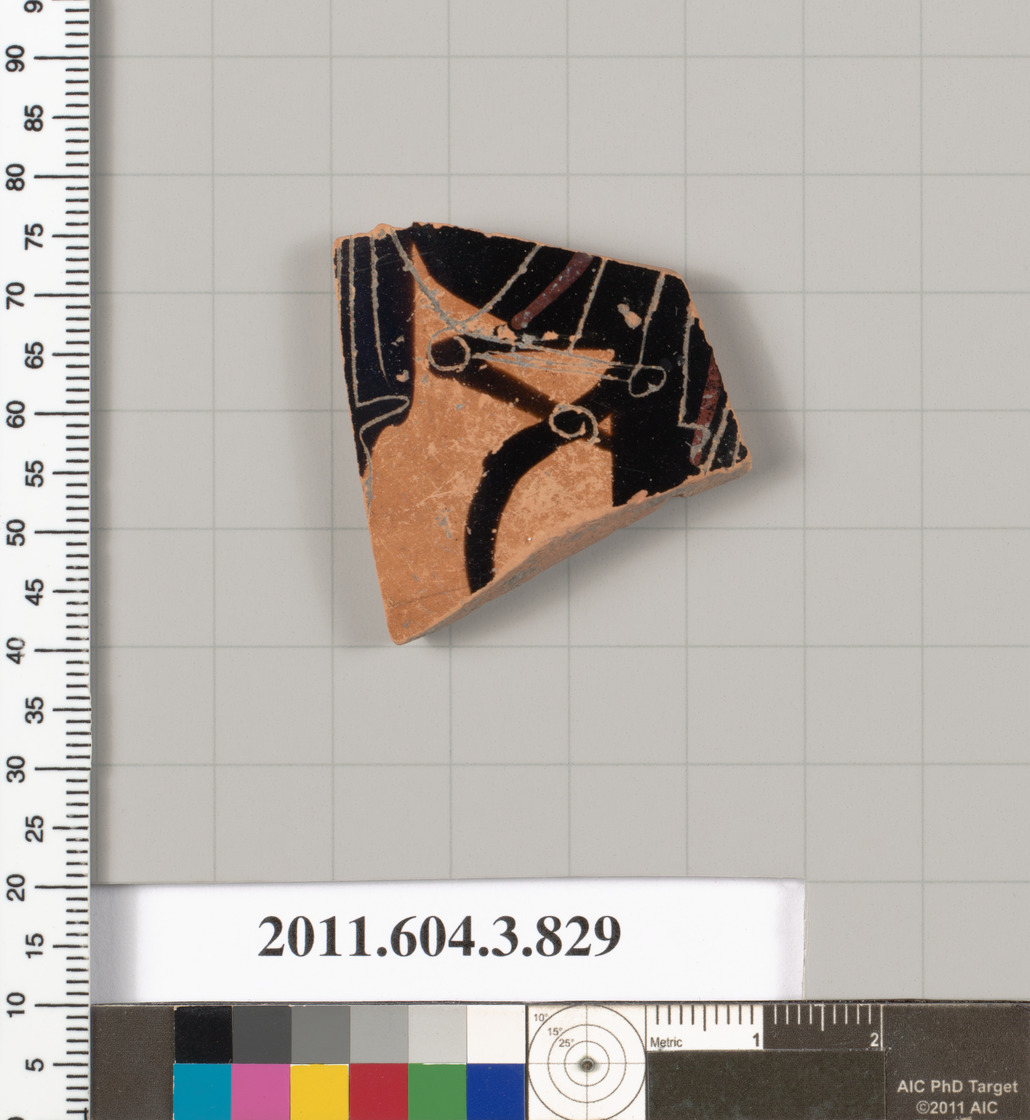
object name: lekythos fragment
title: Terracotta fragment of a lekythos (oil flask)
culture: greek, attic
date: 534-501 BCE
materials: terracotta